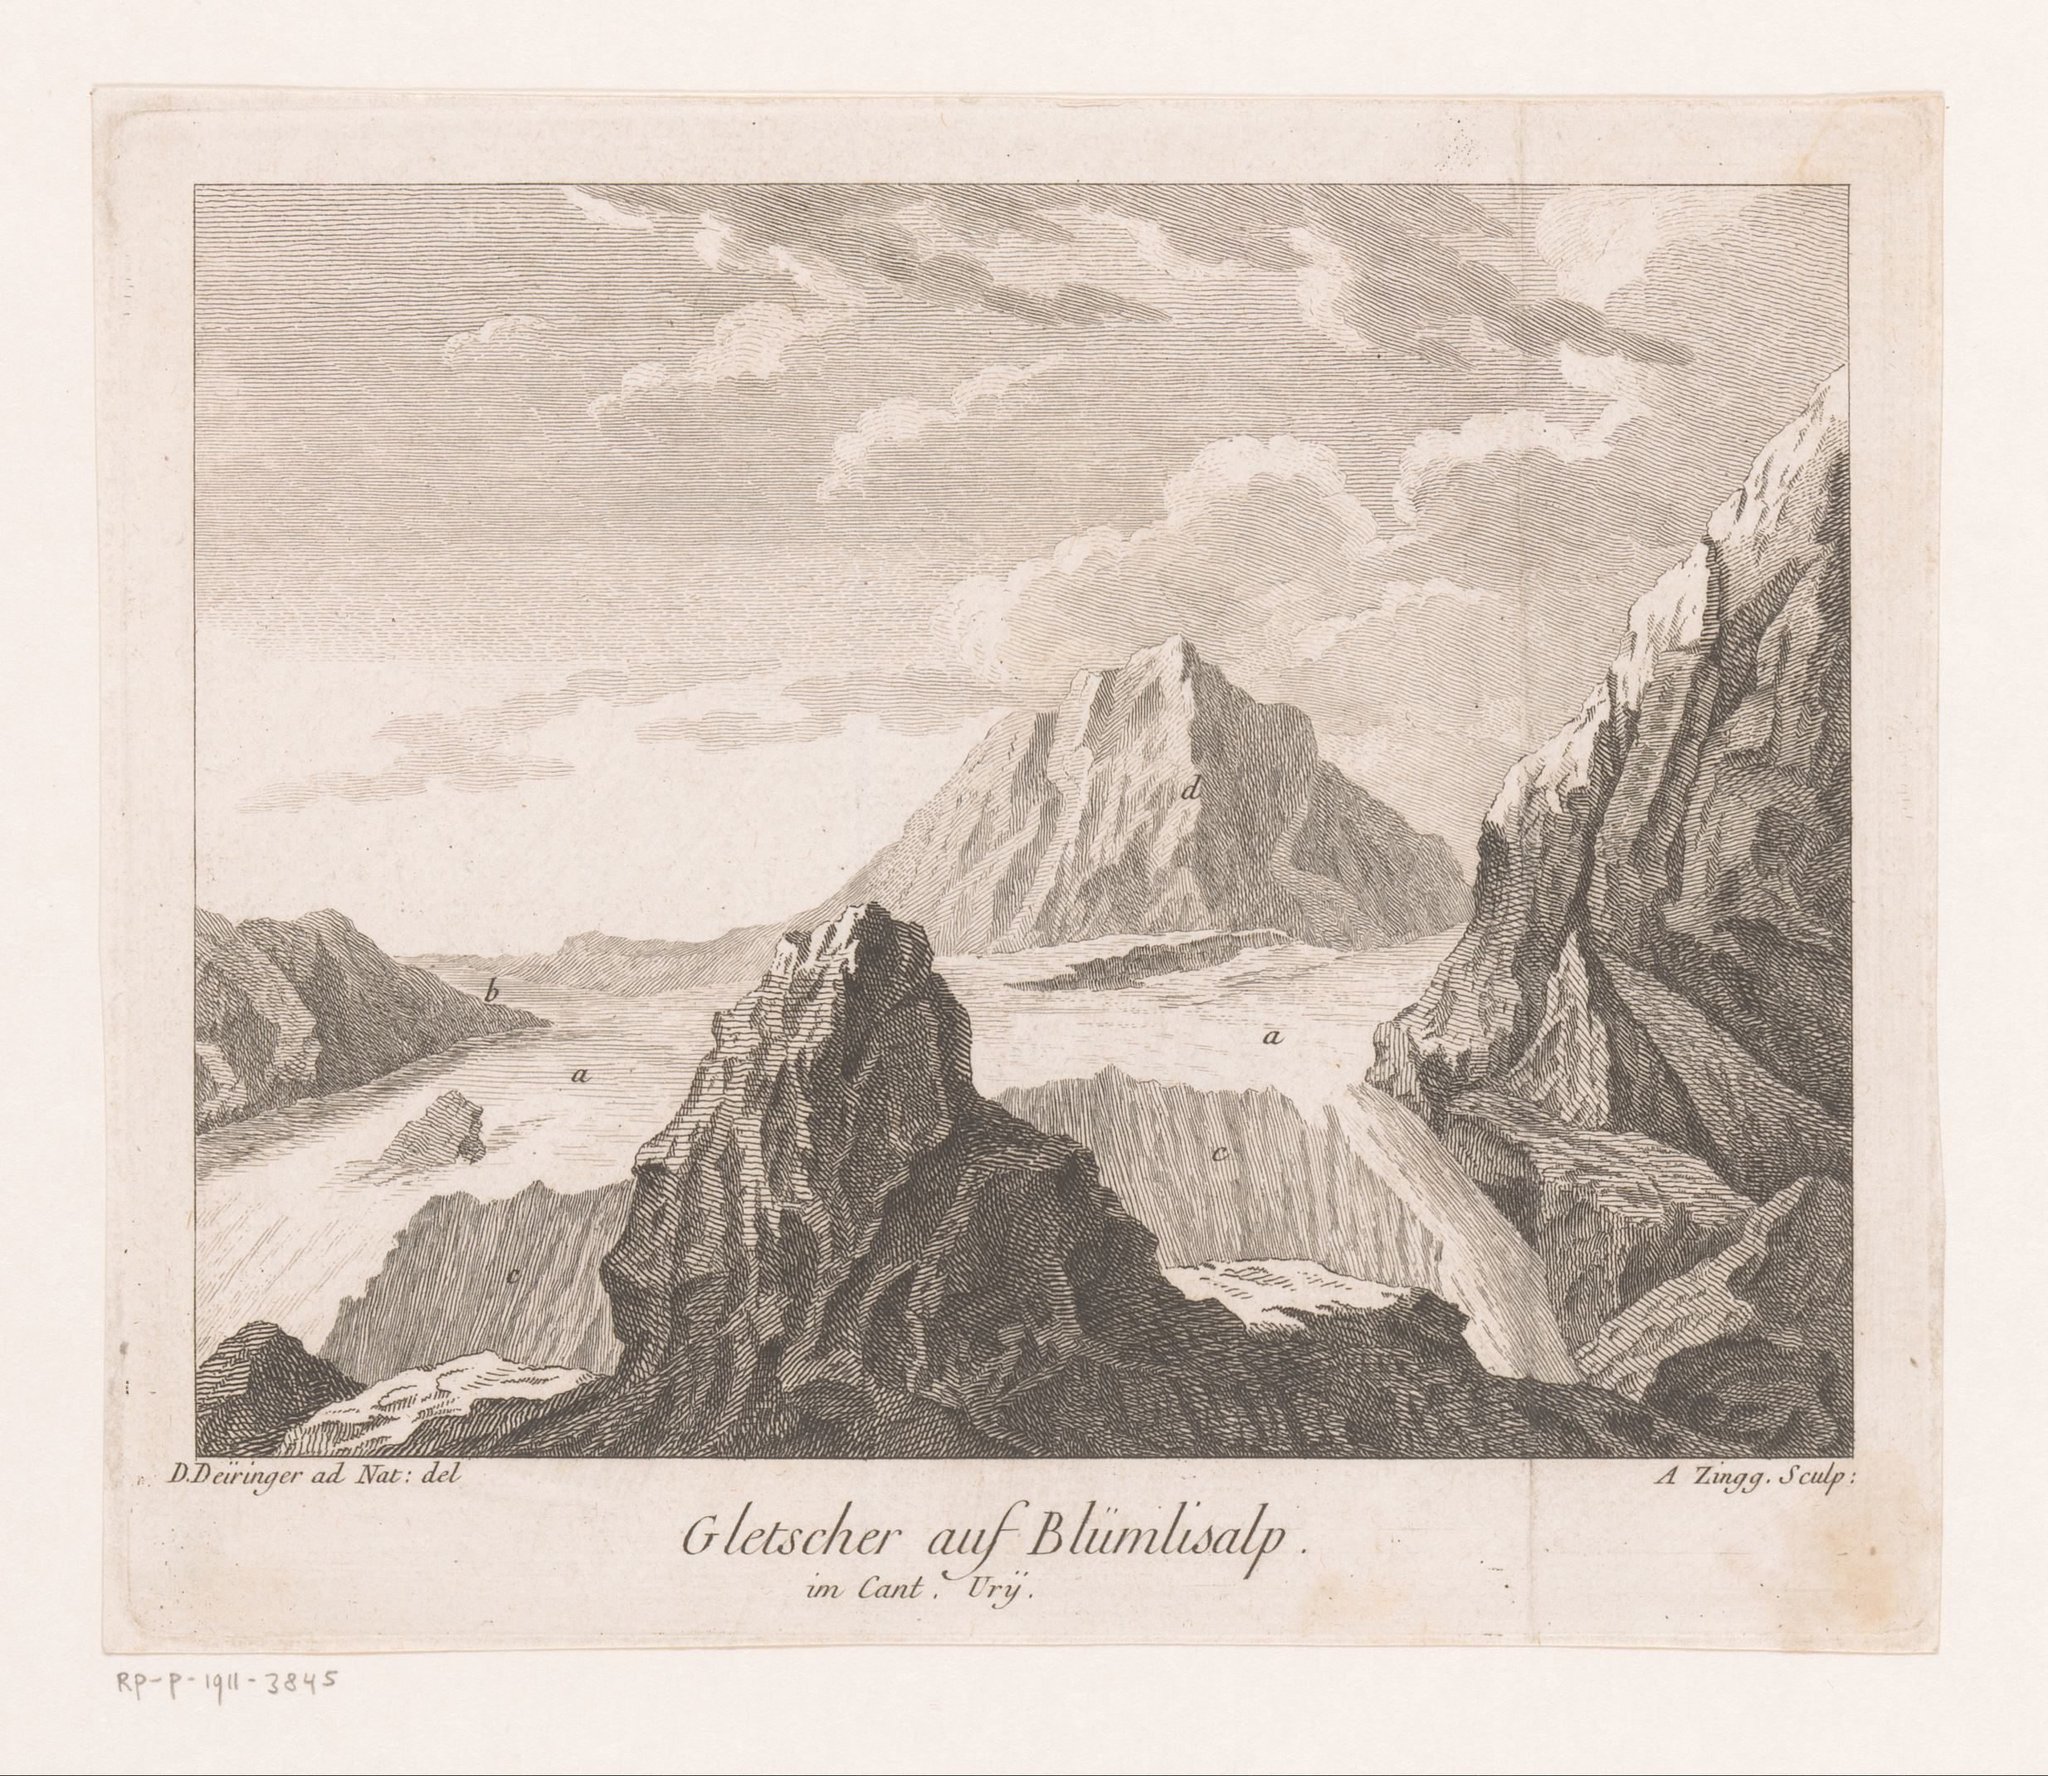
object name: print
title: Gezicht op een gletsjer in de Alpen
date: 1744-1816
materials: paper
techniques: engraving, etching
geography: switzerland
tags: landscapes, glacier, mountains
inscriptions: collector's mark: Lugt 2228